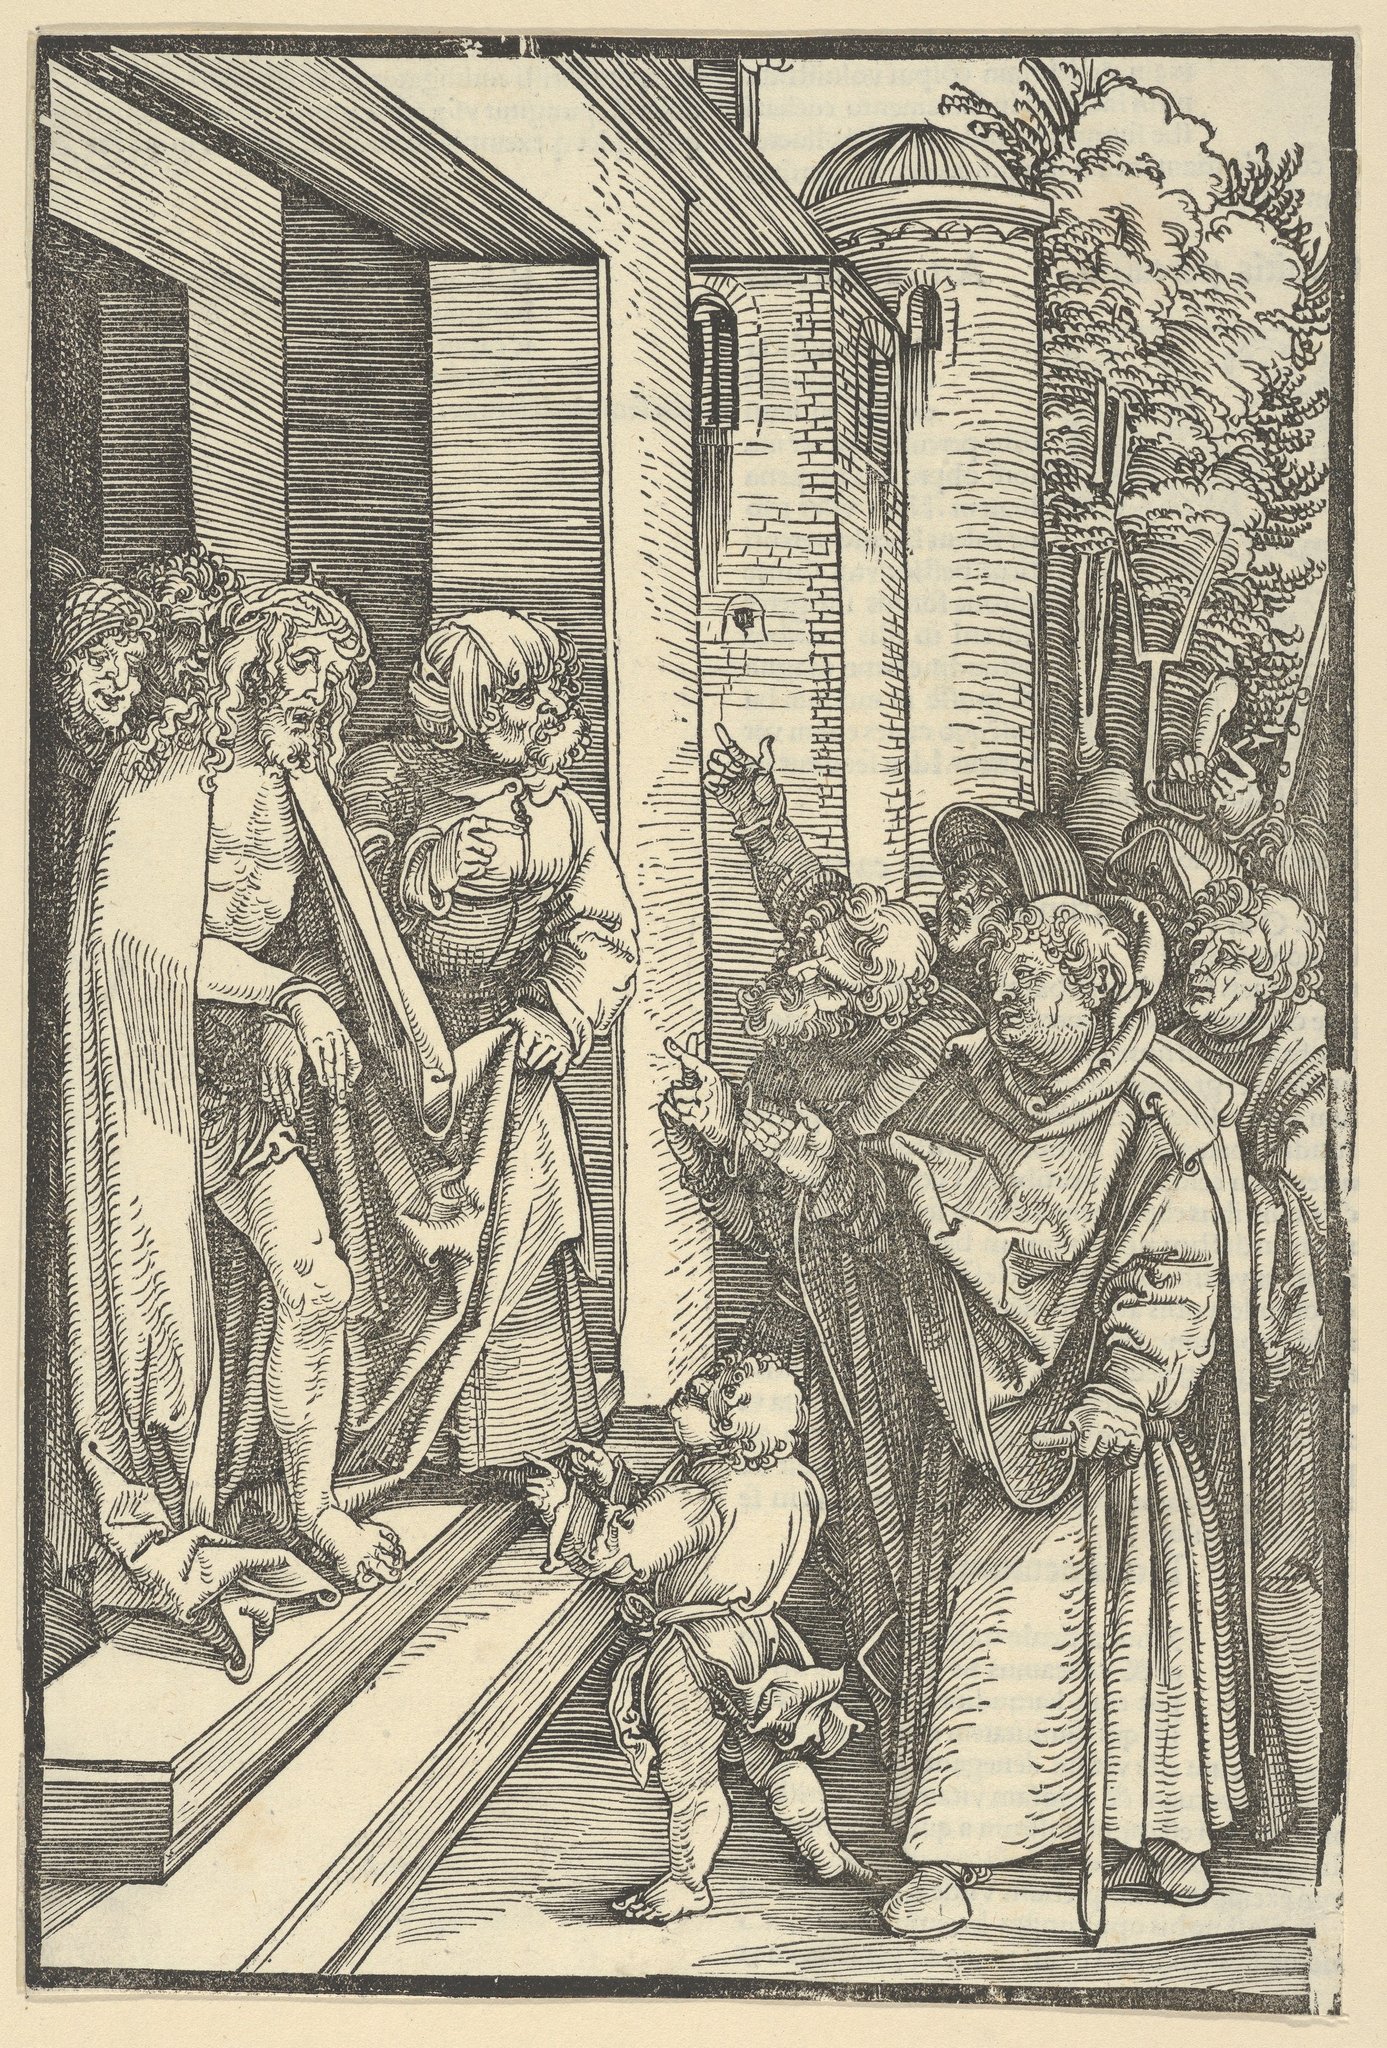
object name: print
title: Ecce Homo, from Speculum passionis domini nostri Ihesu Christi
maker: hans schäufelein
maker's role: artist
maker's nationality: german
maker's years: 1480-1540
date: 1507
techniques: woodcut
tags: suffering,men,women,christ